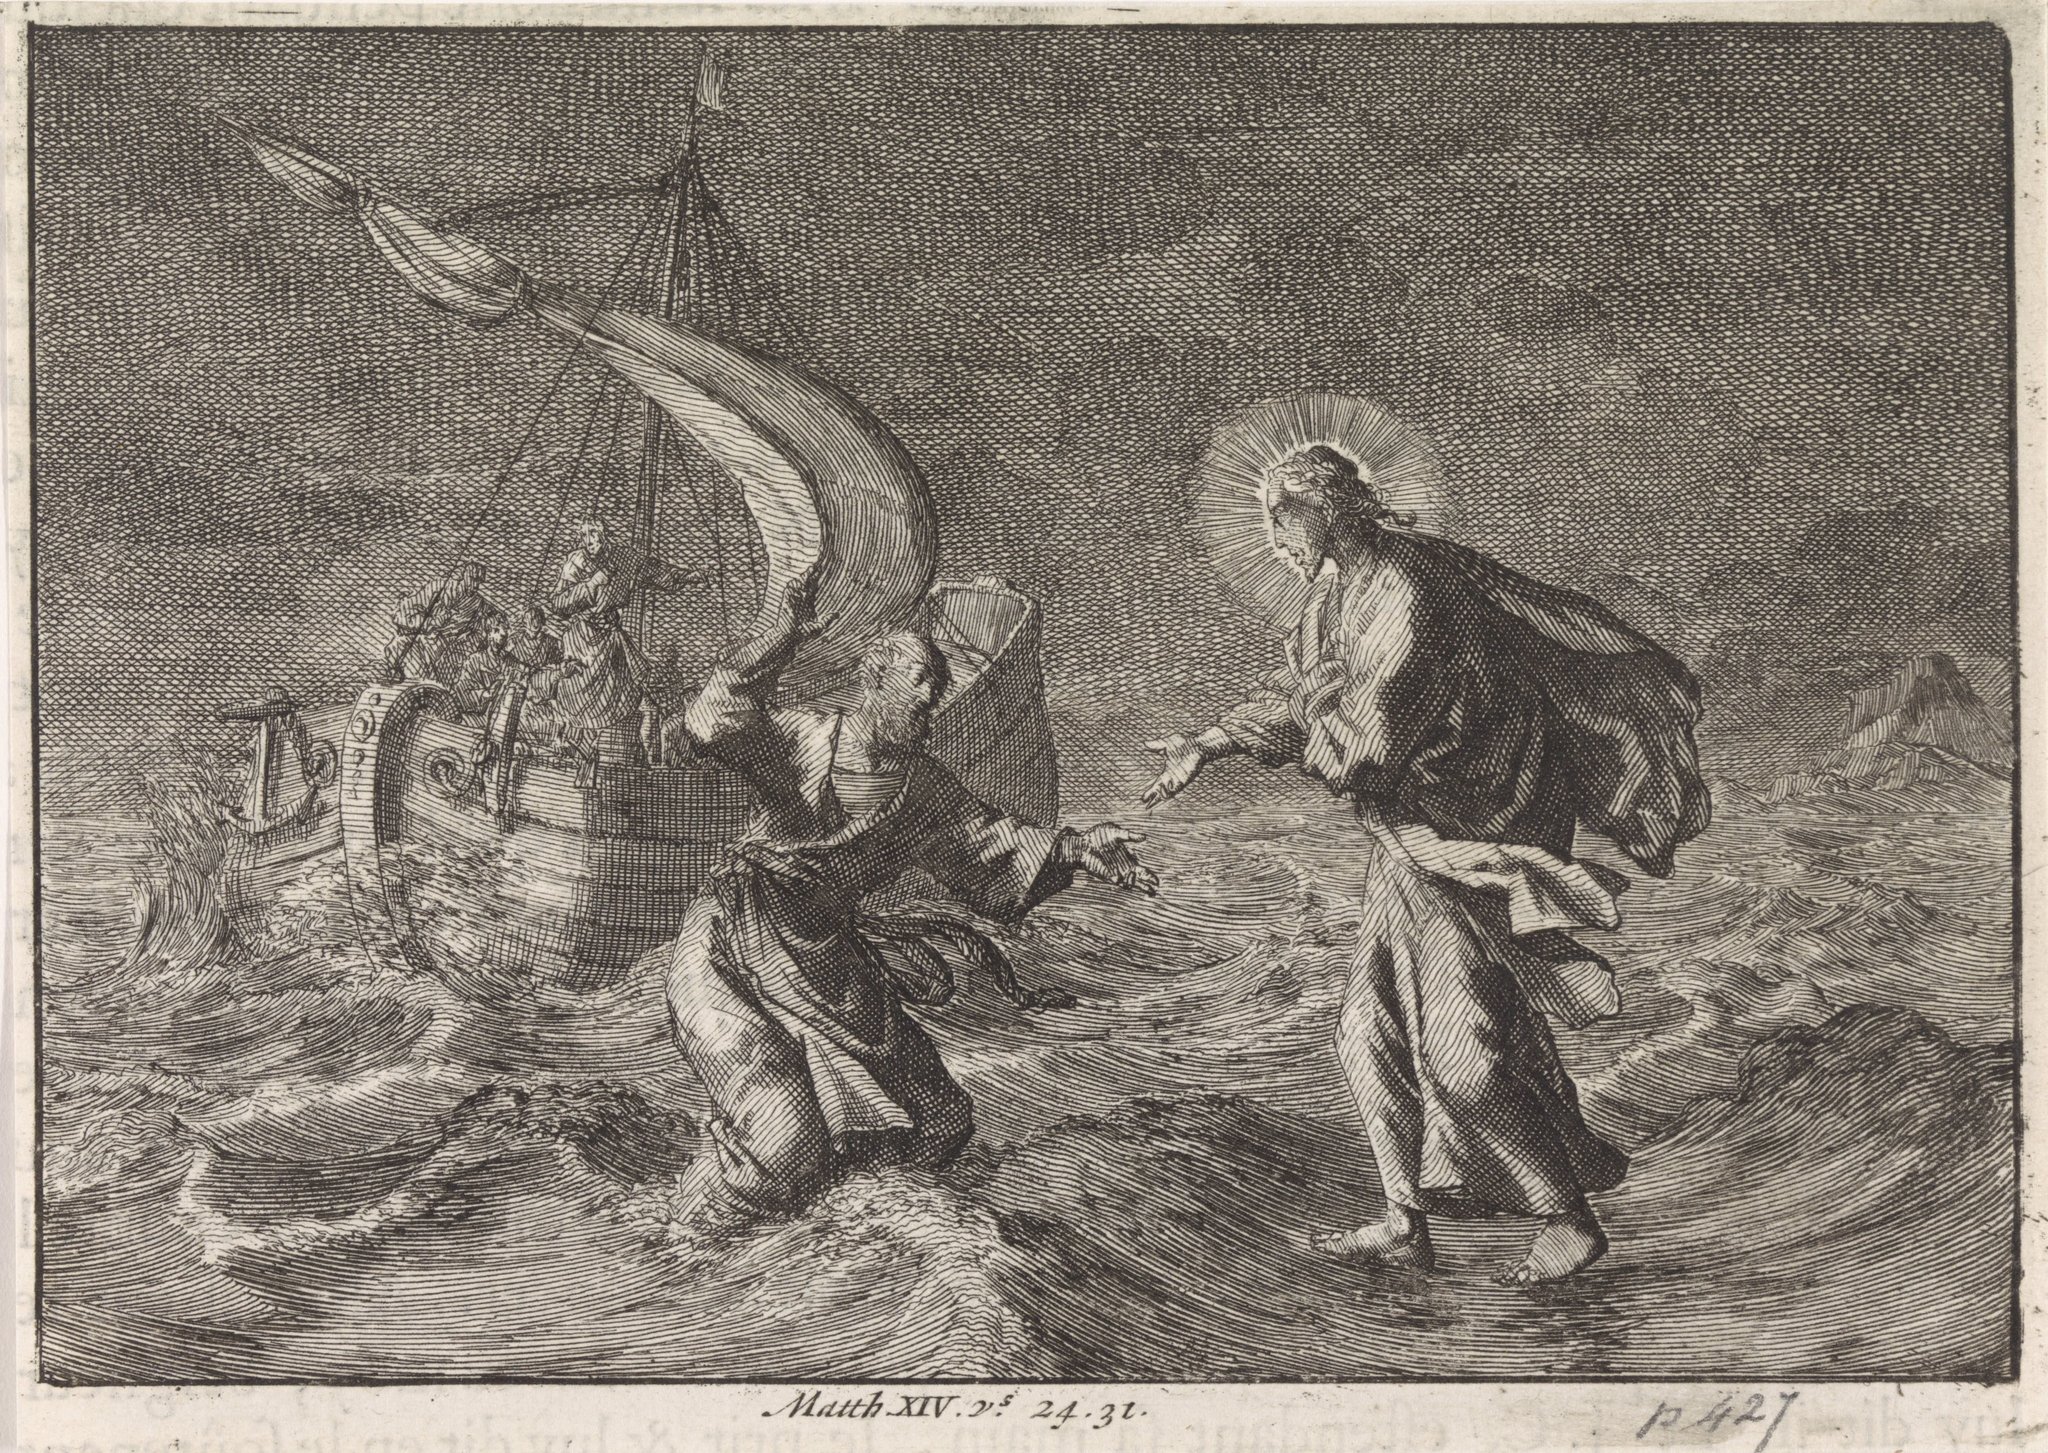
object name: book illustration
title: Christus loopt over het water tijdens een storm op het meer van Galilea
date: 1703-1762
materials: paper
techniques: etching, letterpress printing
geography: haarlem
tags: christ saves peter from drowning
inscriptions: collector's mark: Lugt 2228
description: De prent komt een eerste keer voor als boekillustratie voor David Martin. Historie des Ouden en Nieuwen Testaments. Amsterdam, Pieter Mortier, 1703. Deel II. De boekillustraties voor de Mortierbijbel hebben verschillende staten en kopieën, waarbij de chronologische volgorde moeilijk te achterhalen valt. Als boekillustraties werden ze bovendien herhaaldelijk opnieuw gebruikt voor andere boekwerken.